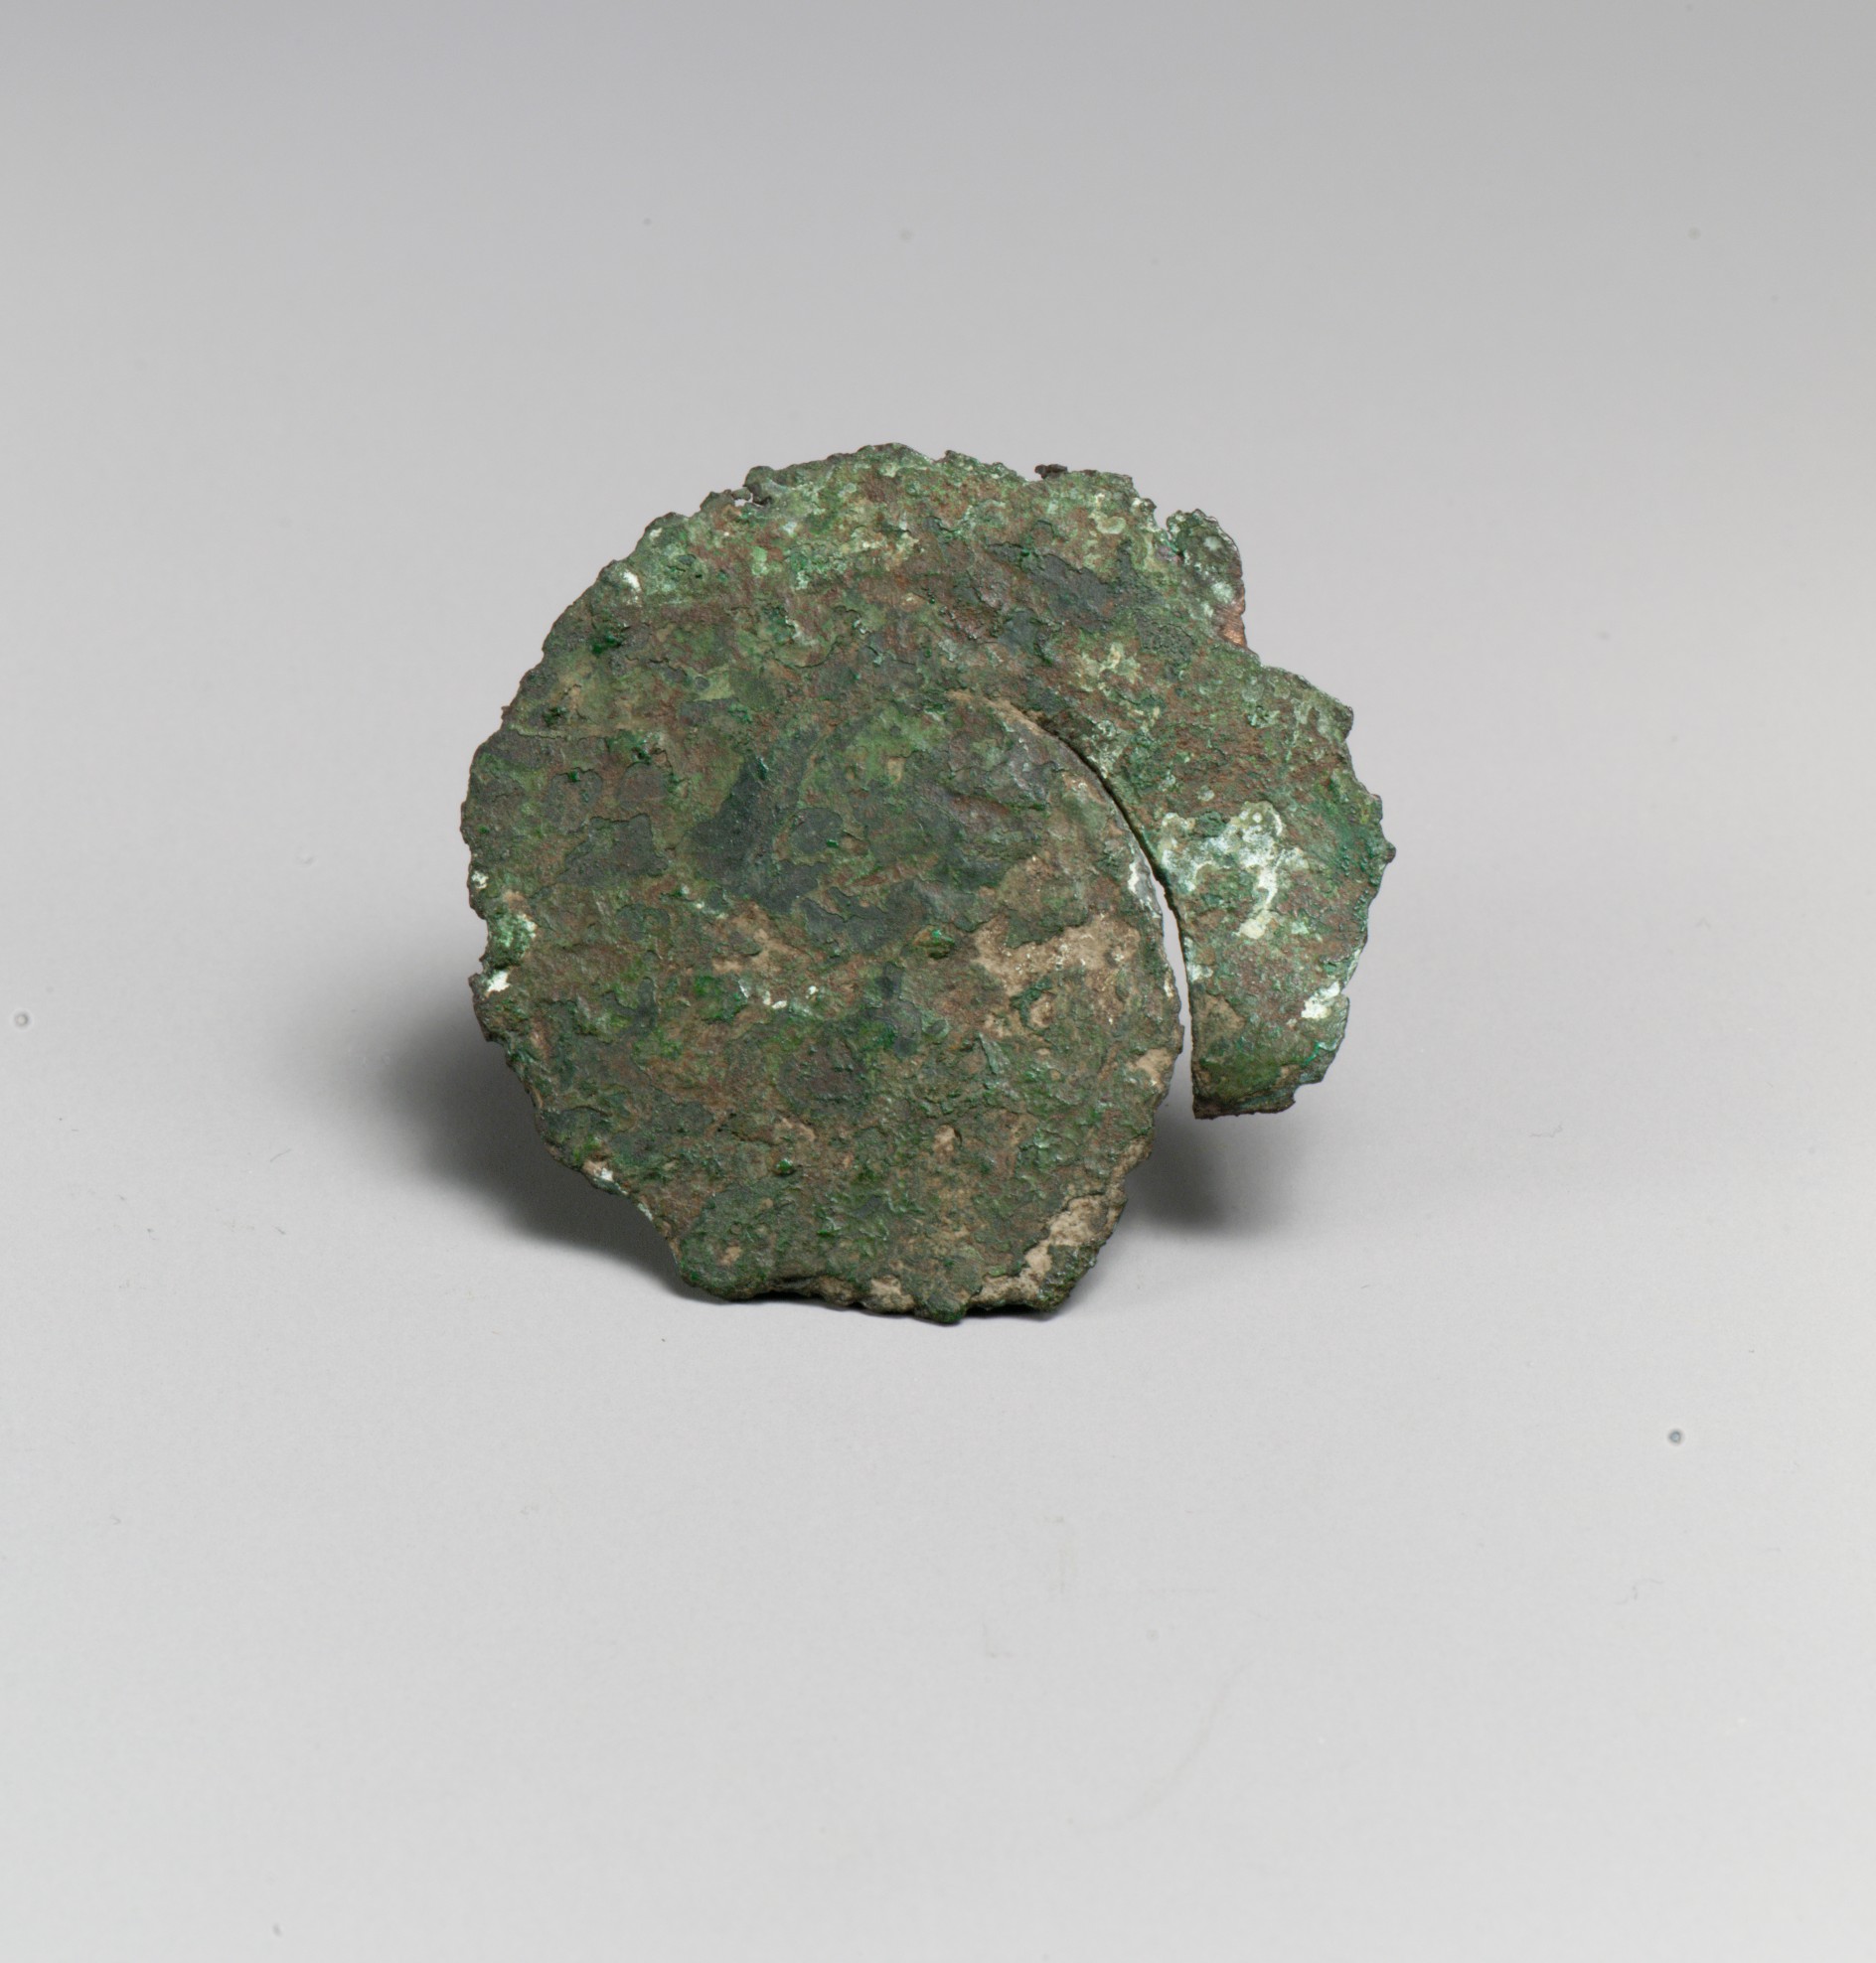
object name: fragment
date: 7000 BCE-330 CE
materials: bronze